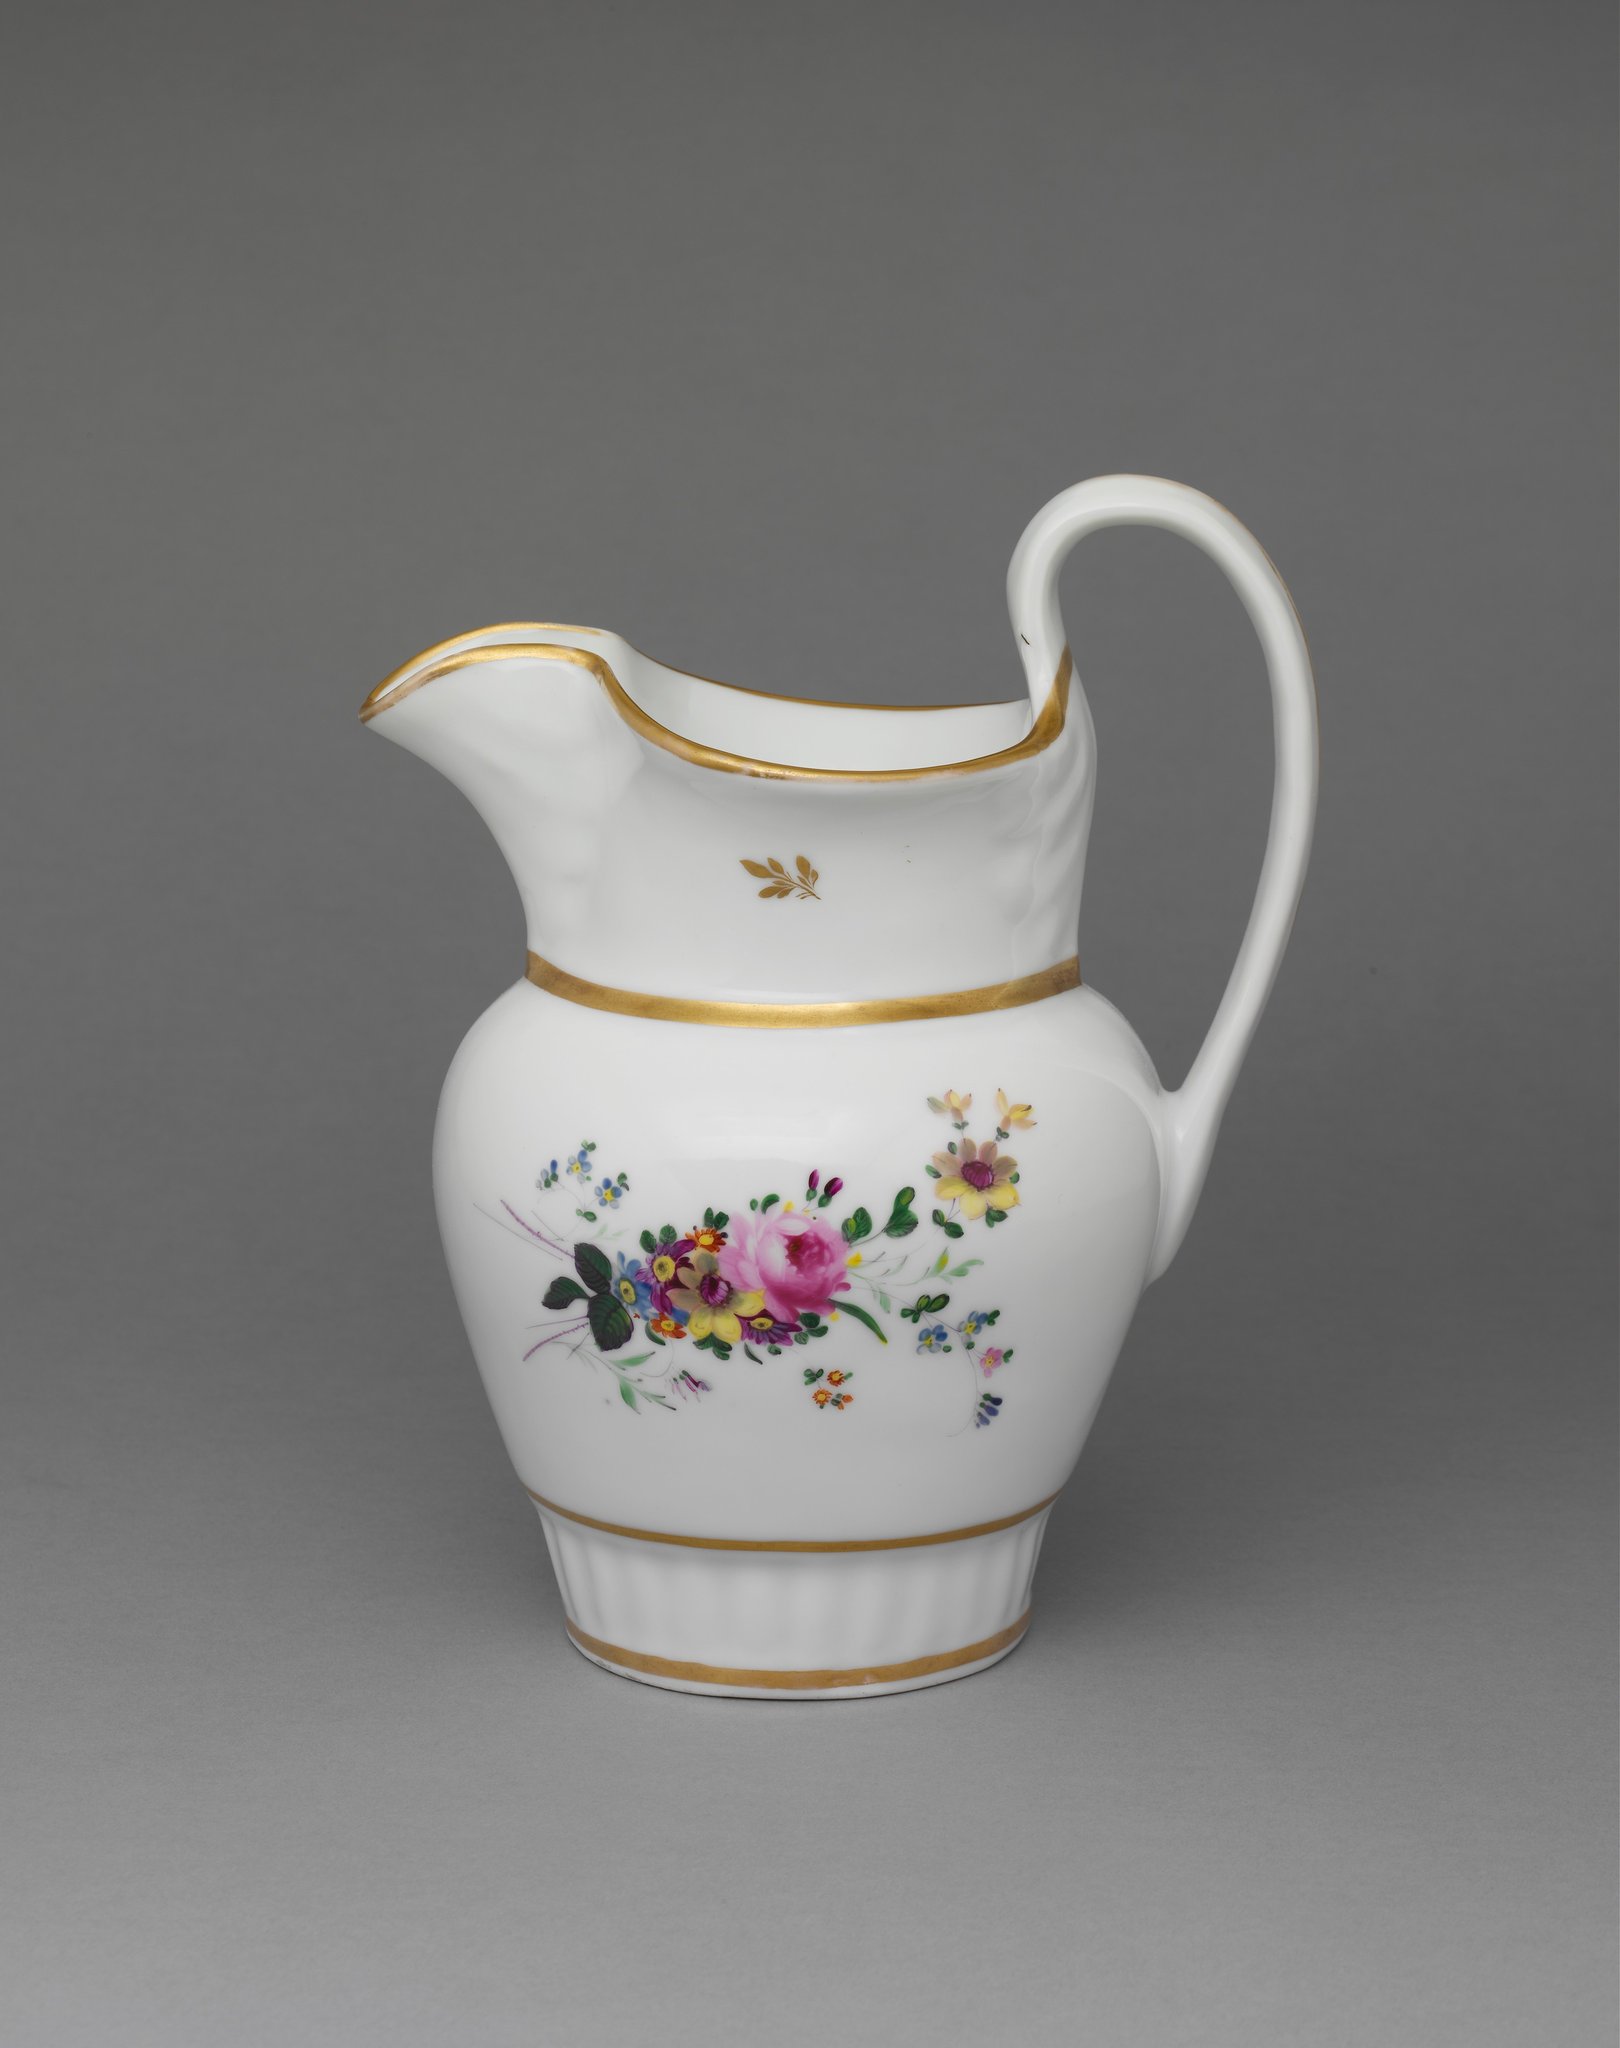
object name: pitcher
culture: american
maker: tucker factory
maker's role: artist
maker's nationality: american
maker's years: 1826-1838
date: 1828-1838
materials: porcelain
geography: united states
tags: flowers